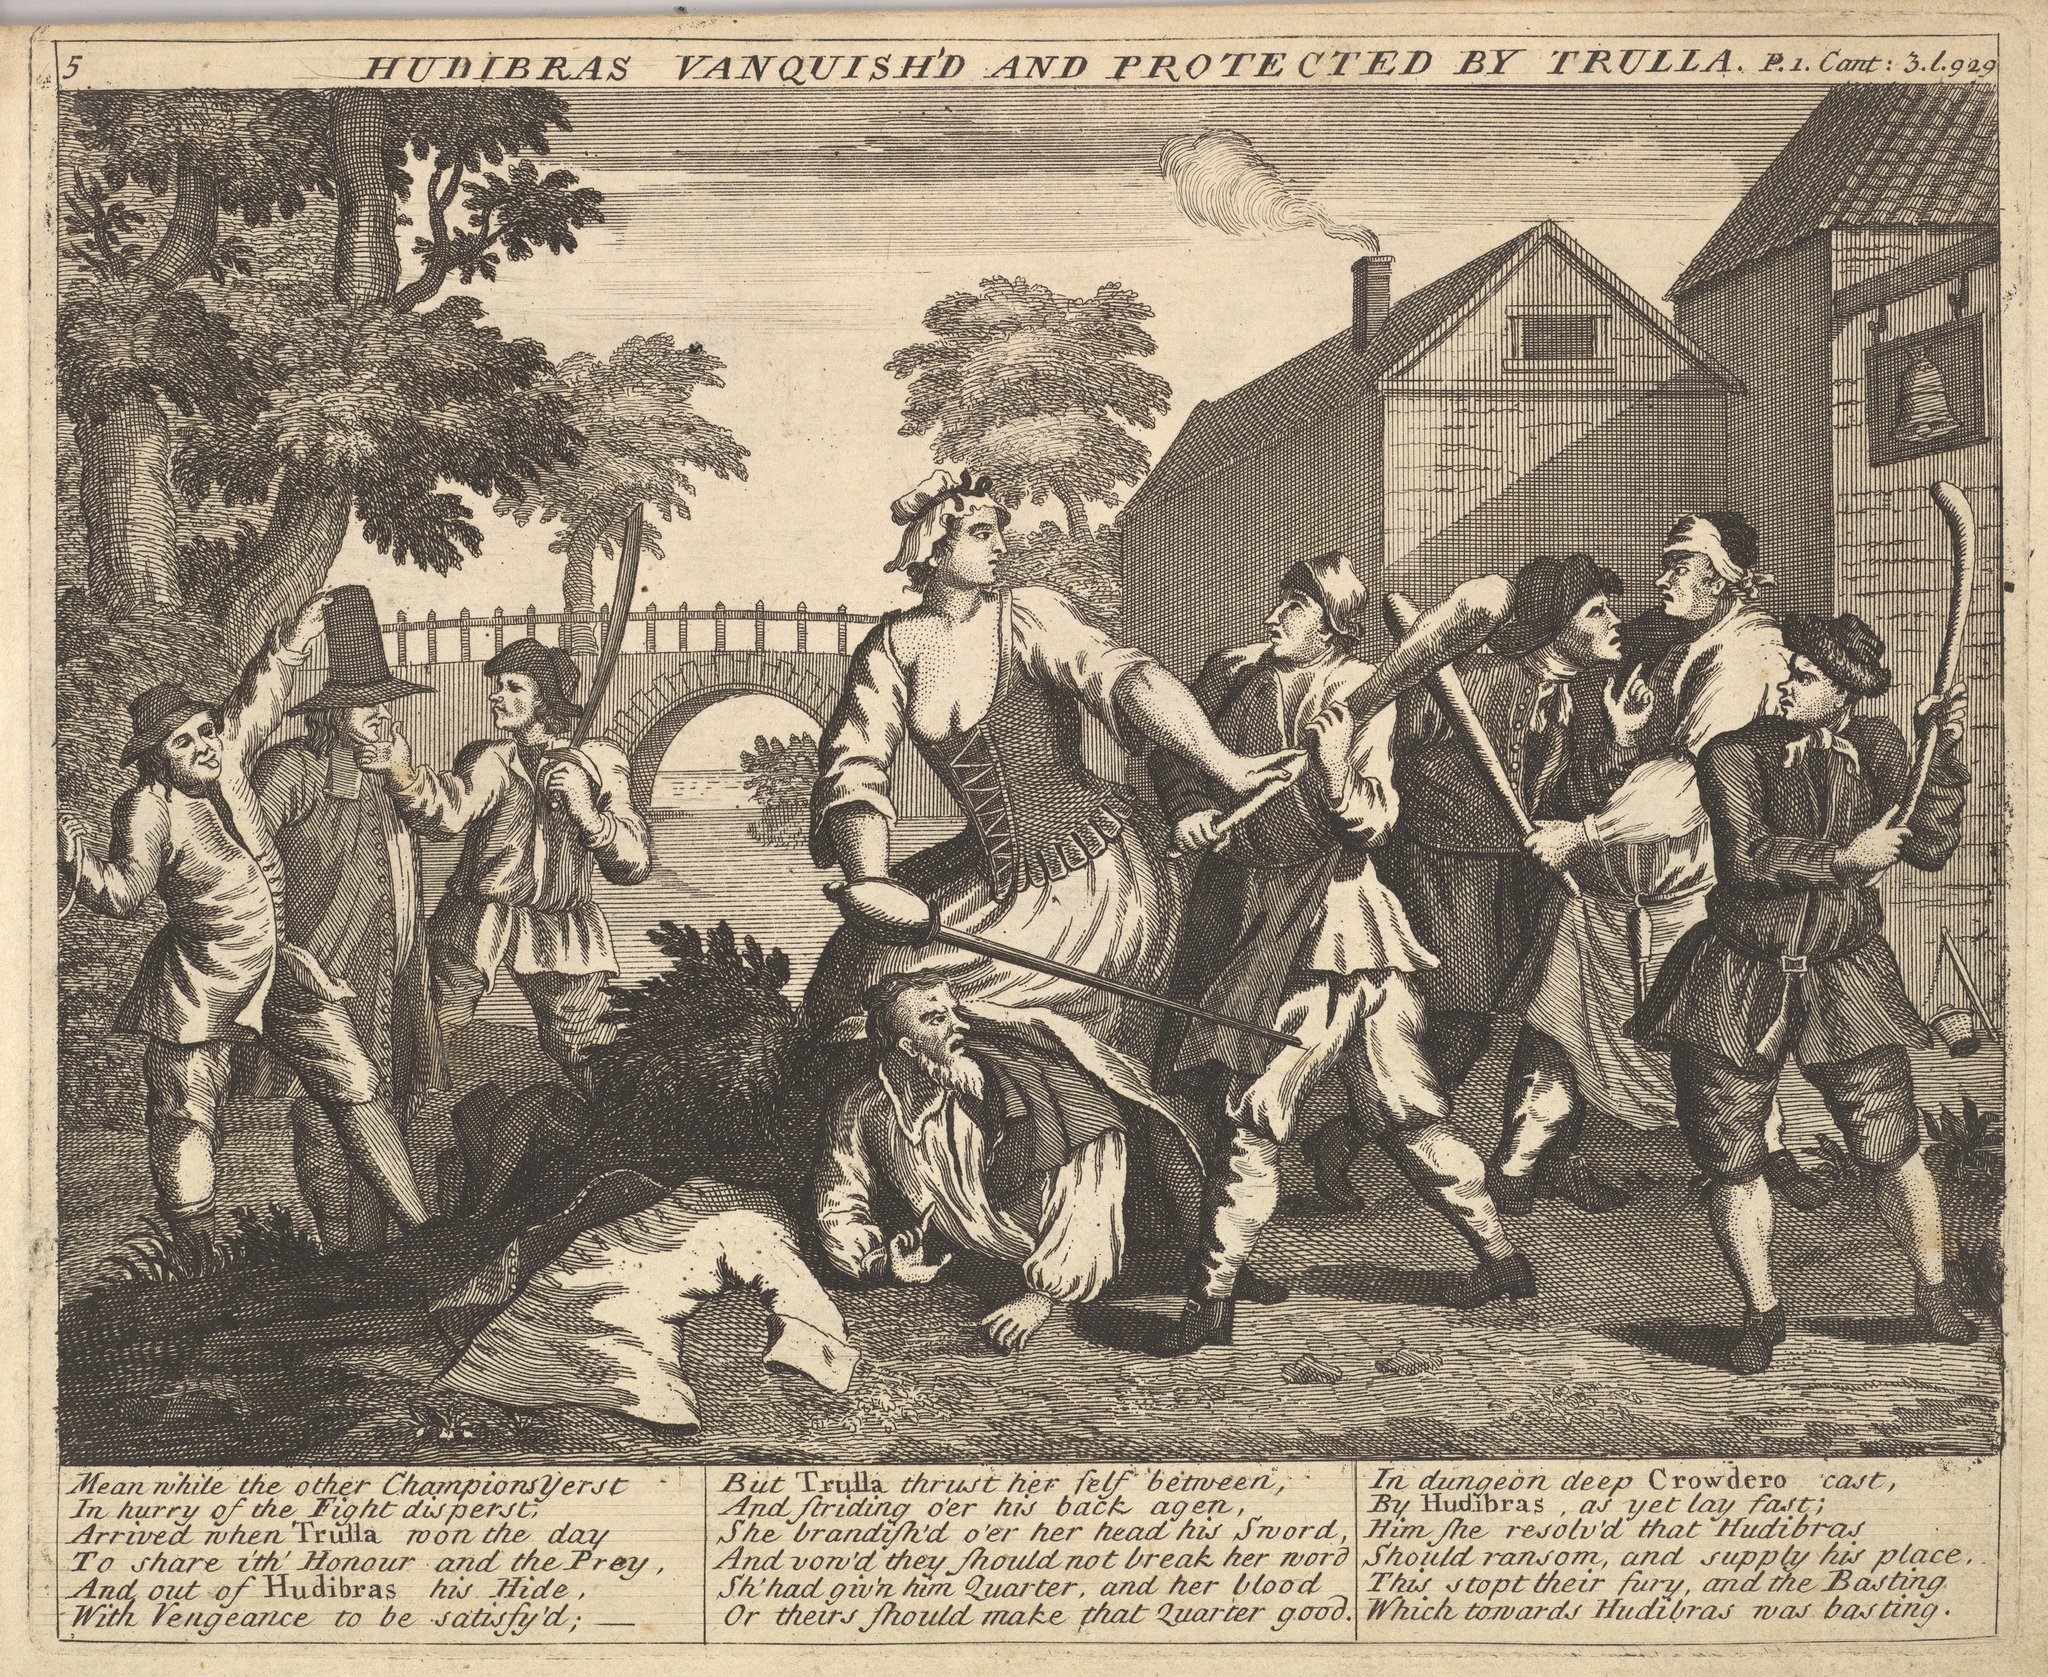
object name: print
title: Hudibras Vanquish'd and Protected by Trulla (Plate 5: Illustrations to Samuel Butler's Hudibras)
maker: william hogarth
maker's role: artist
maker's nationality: british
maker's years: 1697-1764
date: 1725-1730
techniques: engraving, etching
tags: men,women